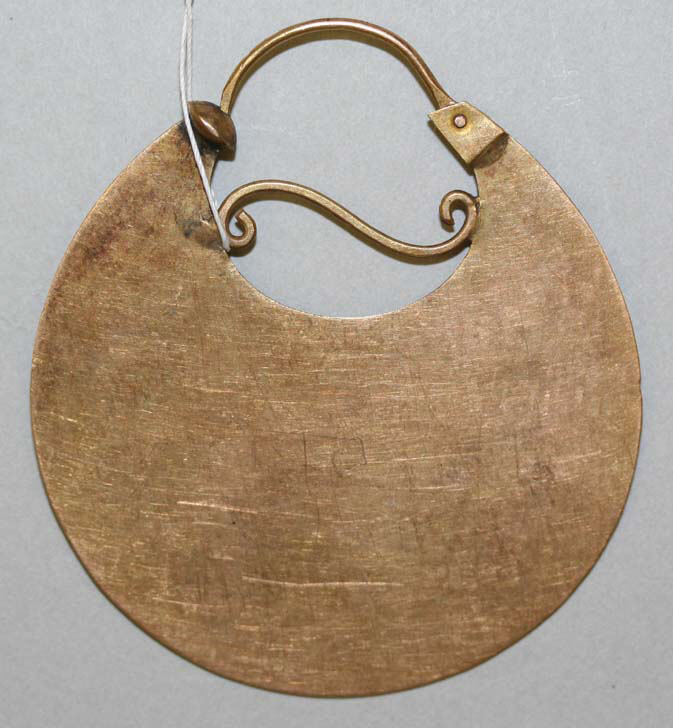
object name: earring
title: Earrings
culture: spanish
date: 1501-1900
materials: gold